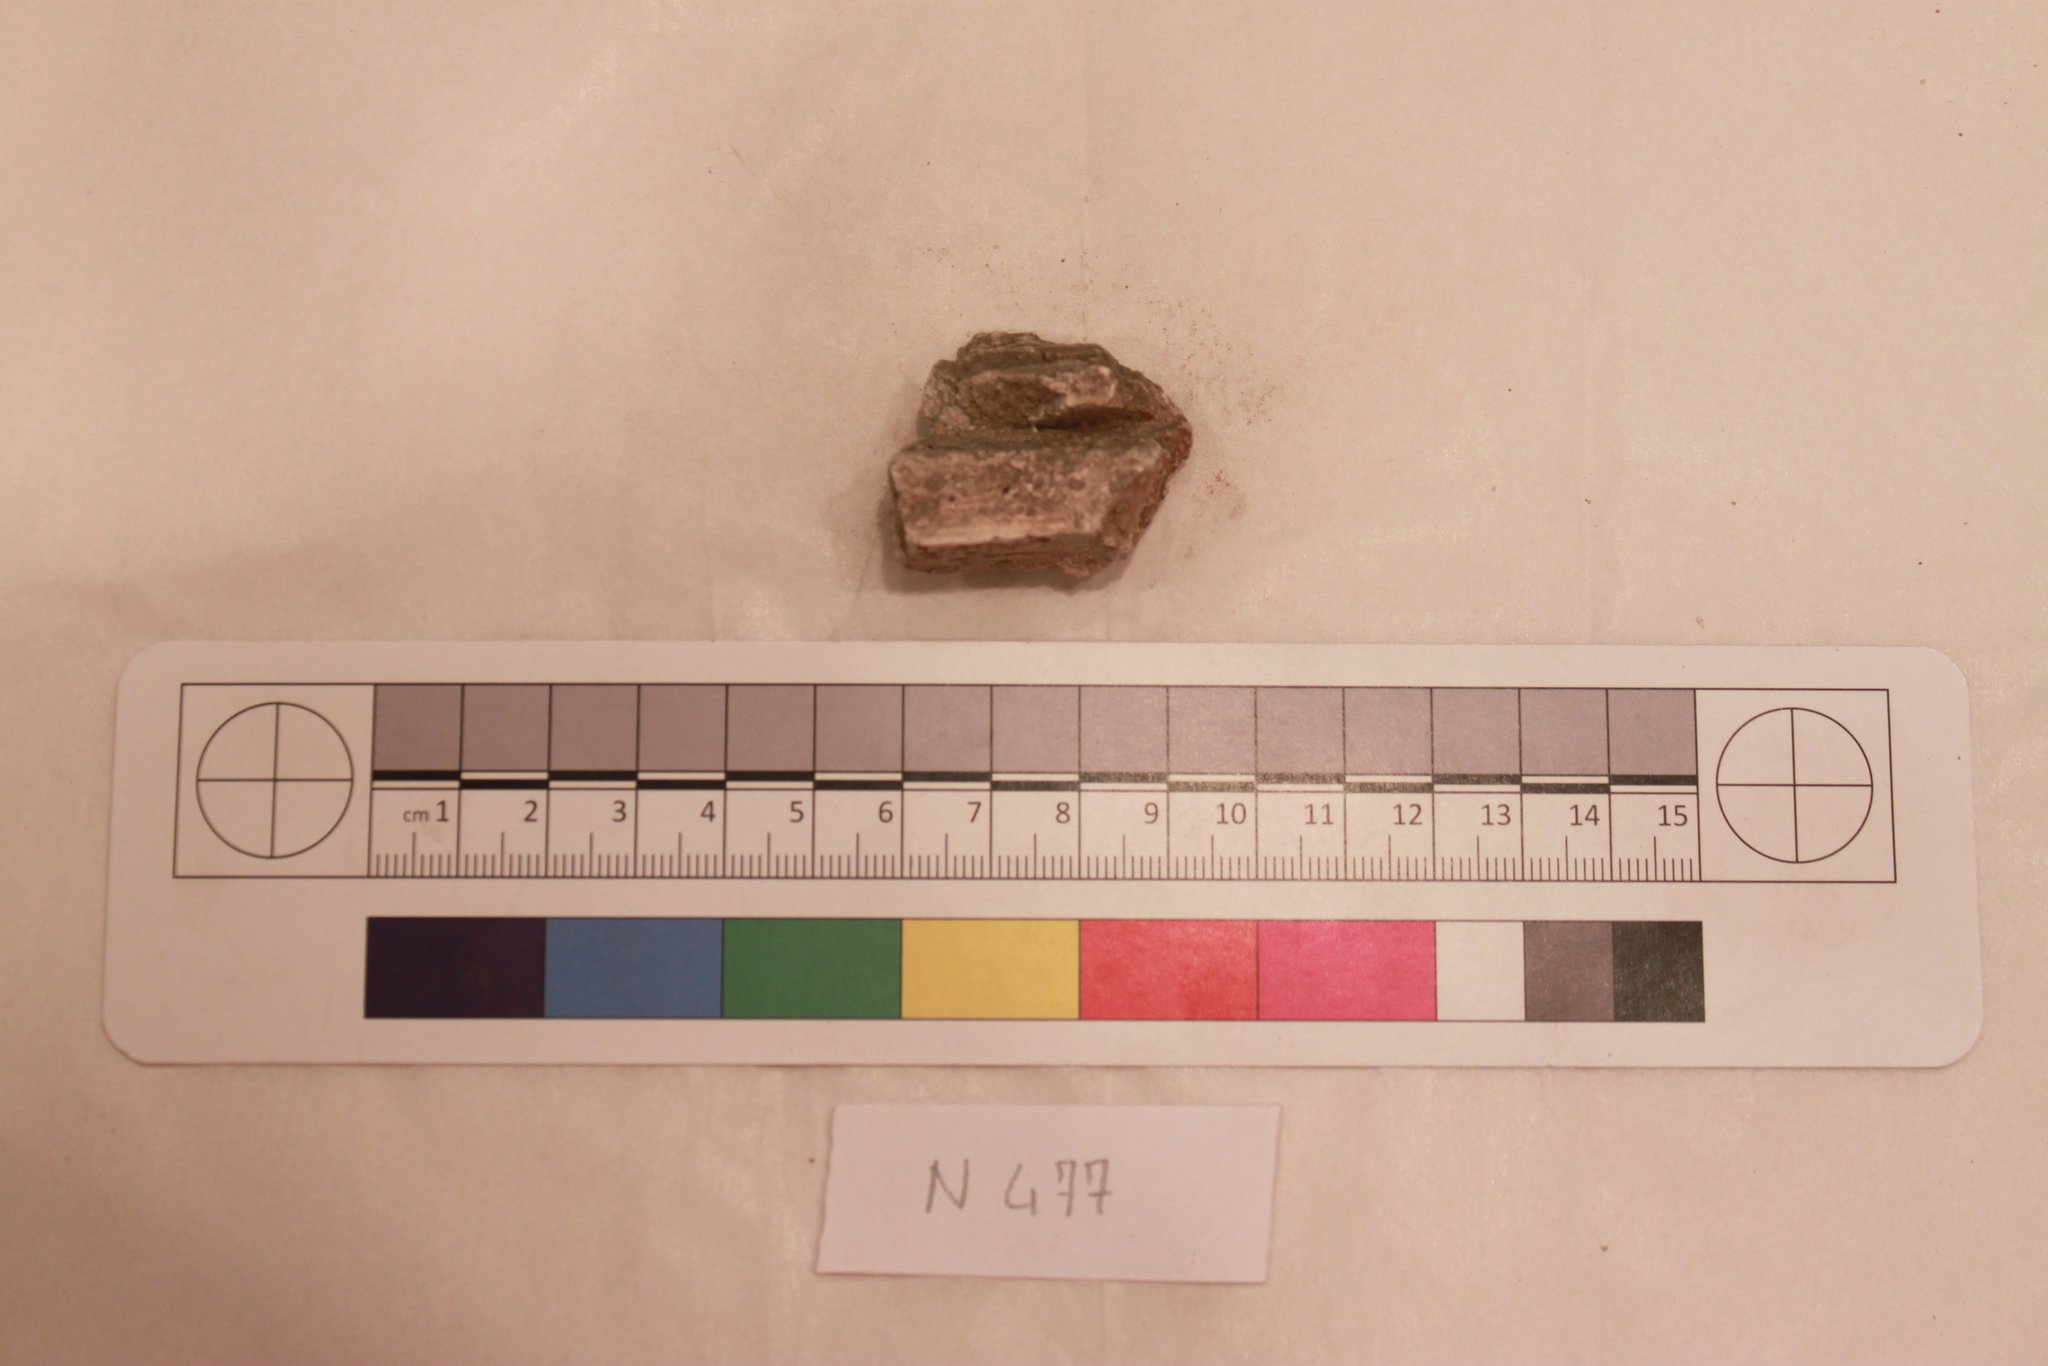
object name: fragment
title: Stucco Fragment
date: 701-1200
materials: plaster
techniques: carving, painting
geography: iran